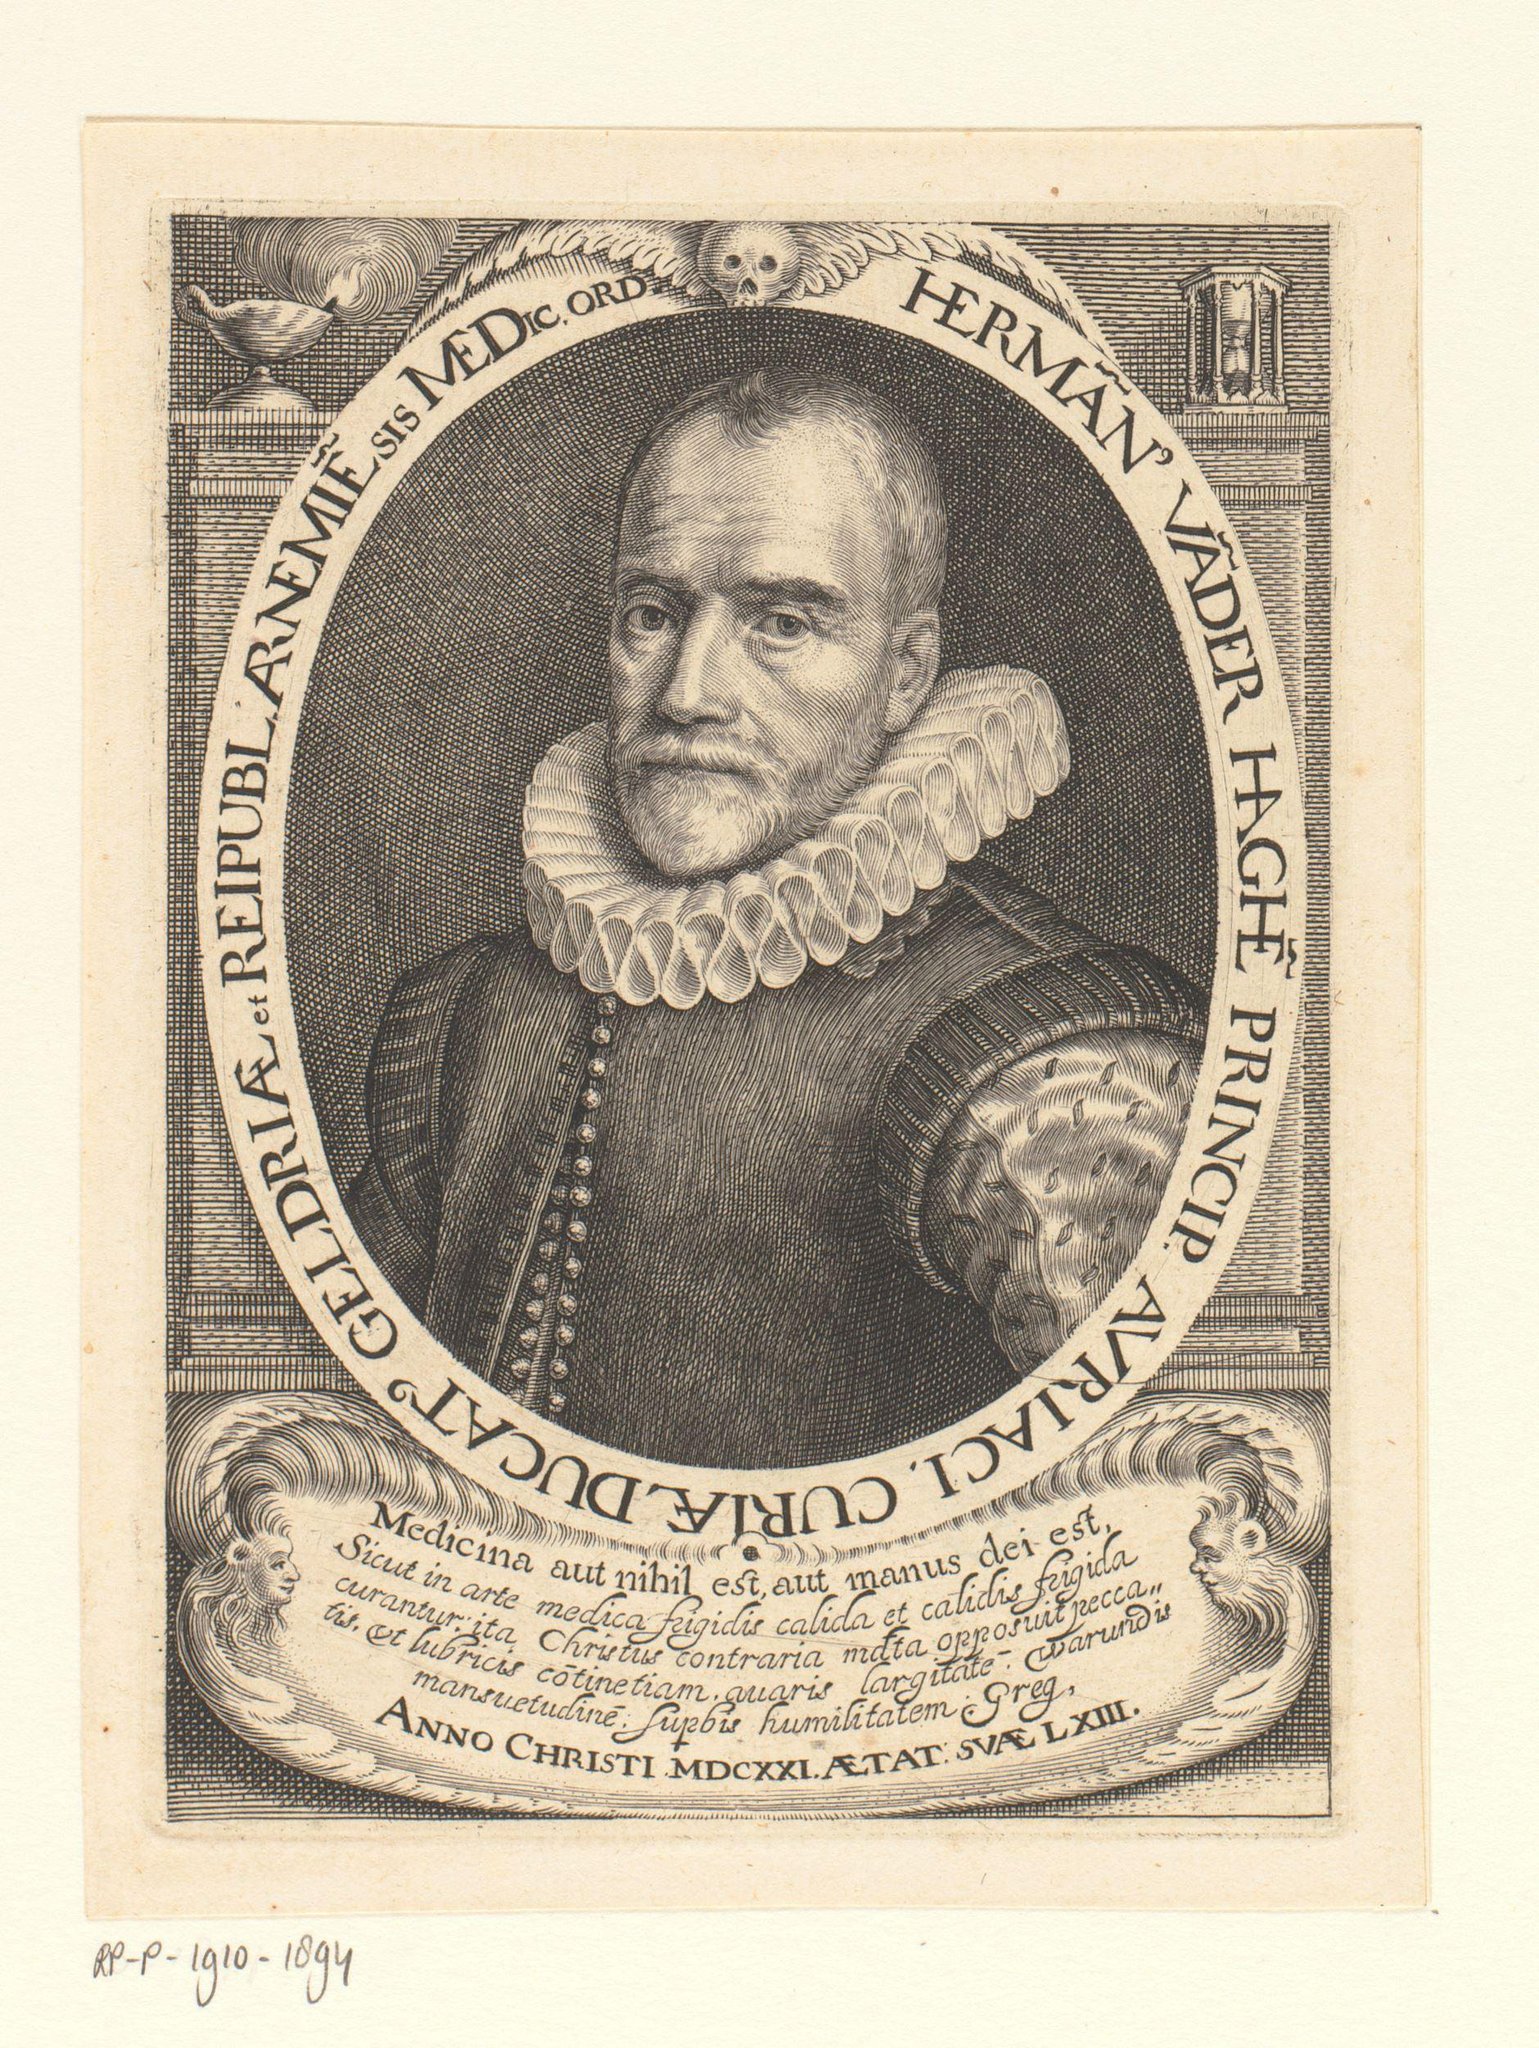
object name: print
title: Portret van Herman van der Haghe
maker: Anonymous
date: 1621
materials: paper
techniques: engraving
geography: netherlands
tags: herman van der haghe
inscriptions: collector's mark: Lugt 2228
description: Portret van Herman van der Haghe op 63-jarige leeftijd. In het randschrift zijn naam en functie. Onder het portret een cartouche met een vierregelige tekst in het Latijn. Linksboven een brandende lamp, rechtsboven een zandloper.